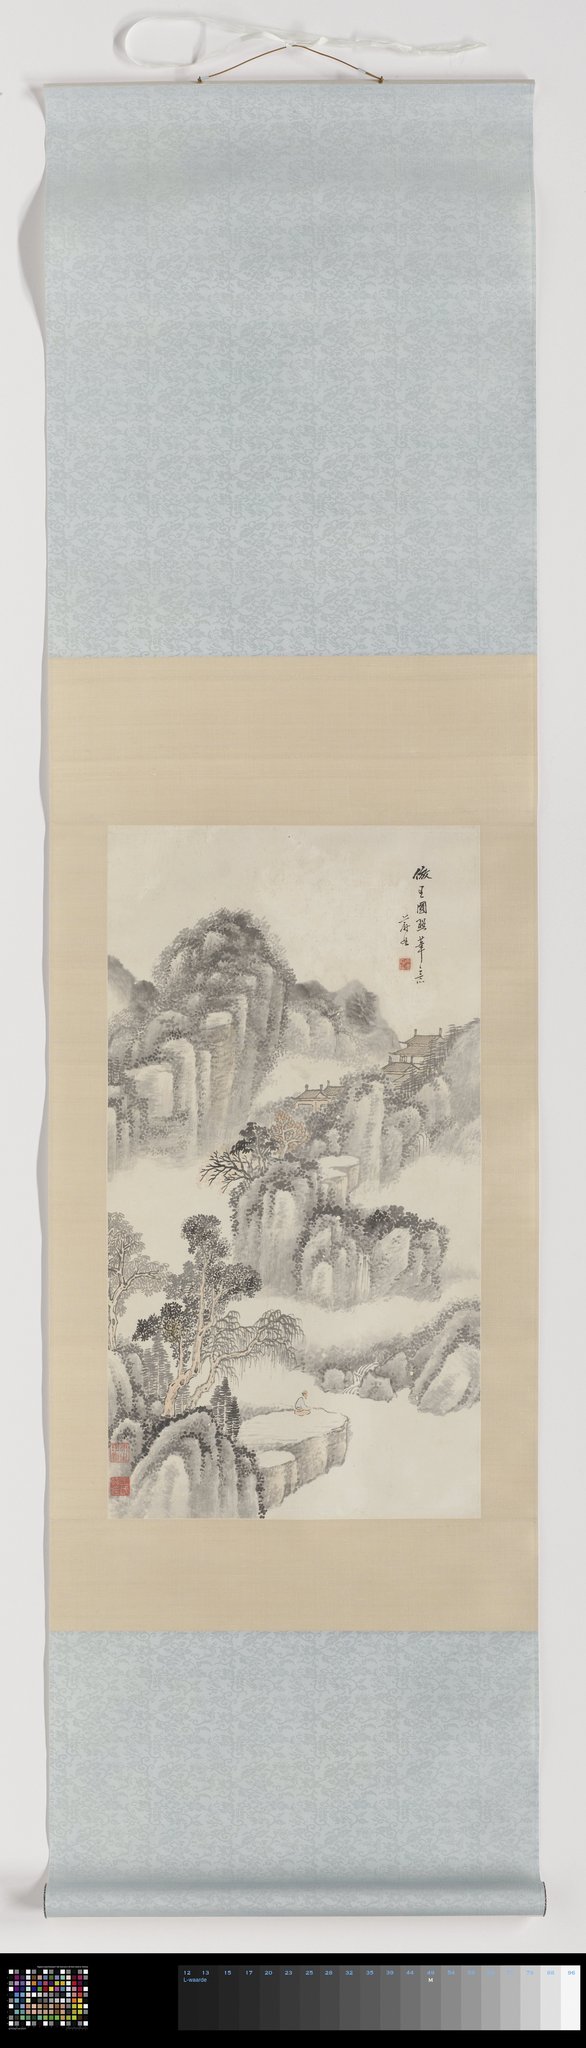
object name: hanging scroll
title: Rolschildering in de stijl van de vier Wangs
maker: xiang wenyan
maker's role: painter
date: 1897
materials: ink, paper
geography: huai'an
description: Rolschildering in de stijl van de vier Wangs. Samen met AK-RAK-1991-2-2, AK-RAK-1991-2-3 en AK-RAK-1991-2-4 in houten doos.